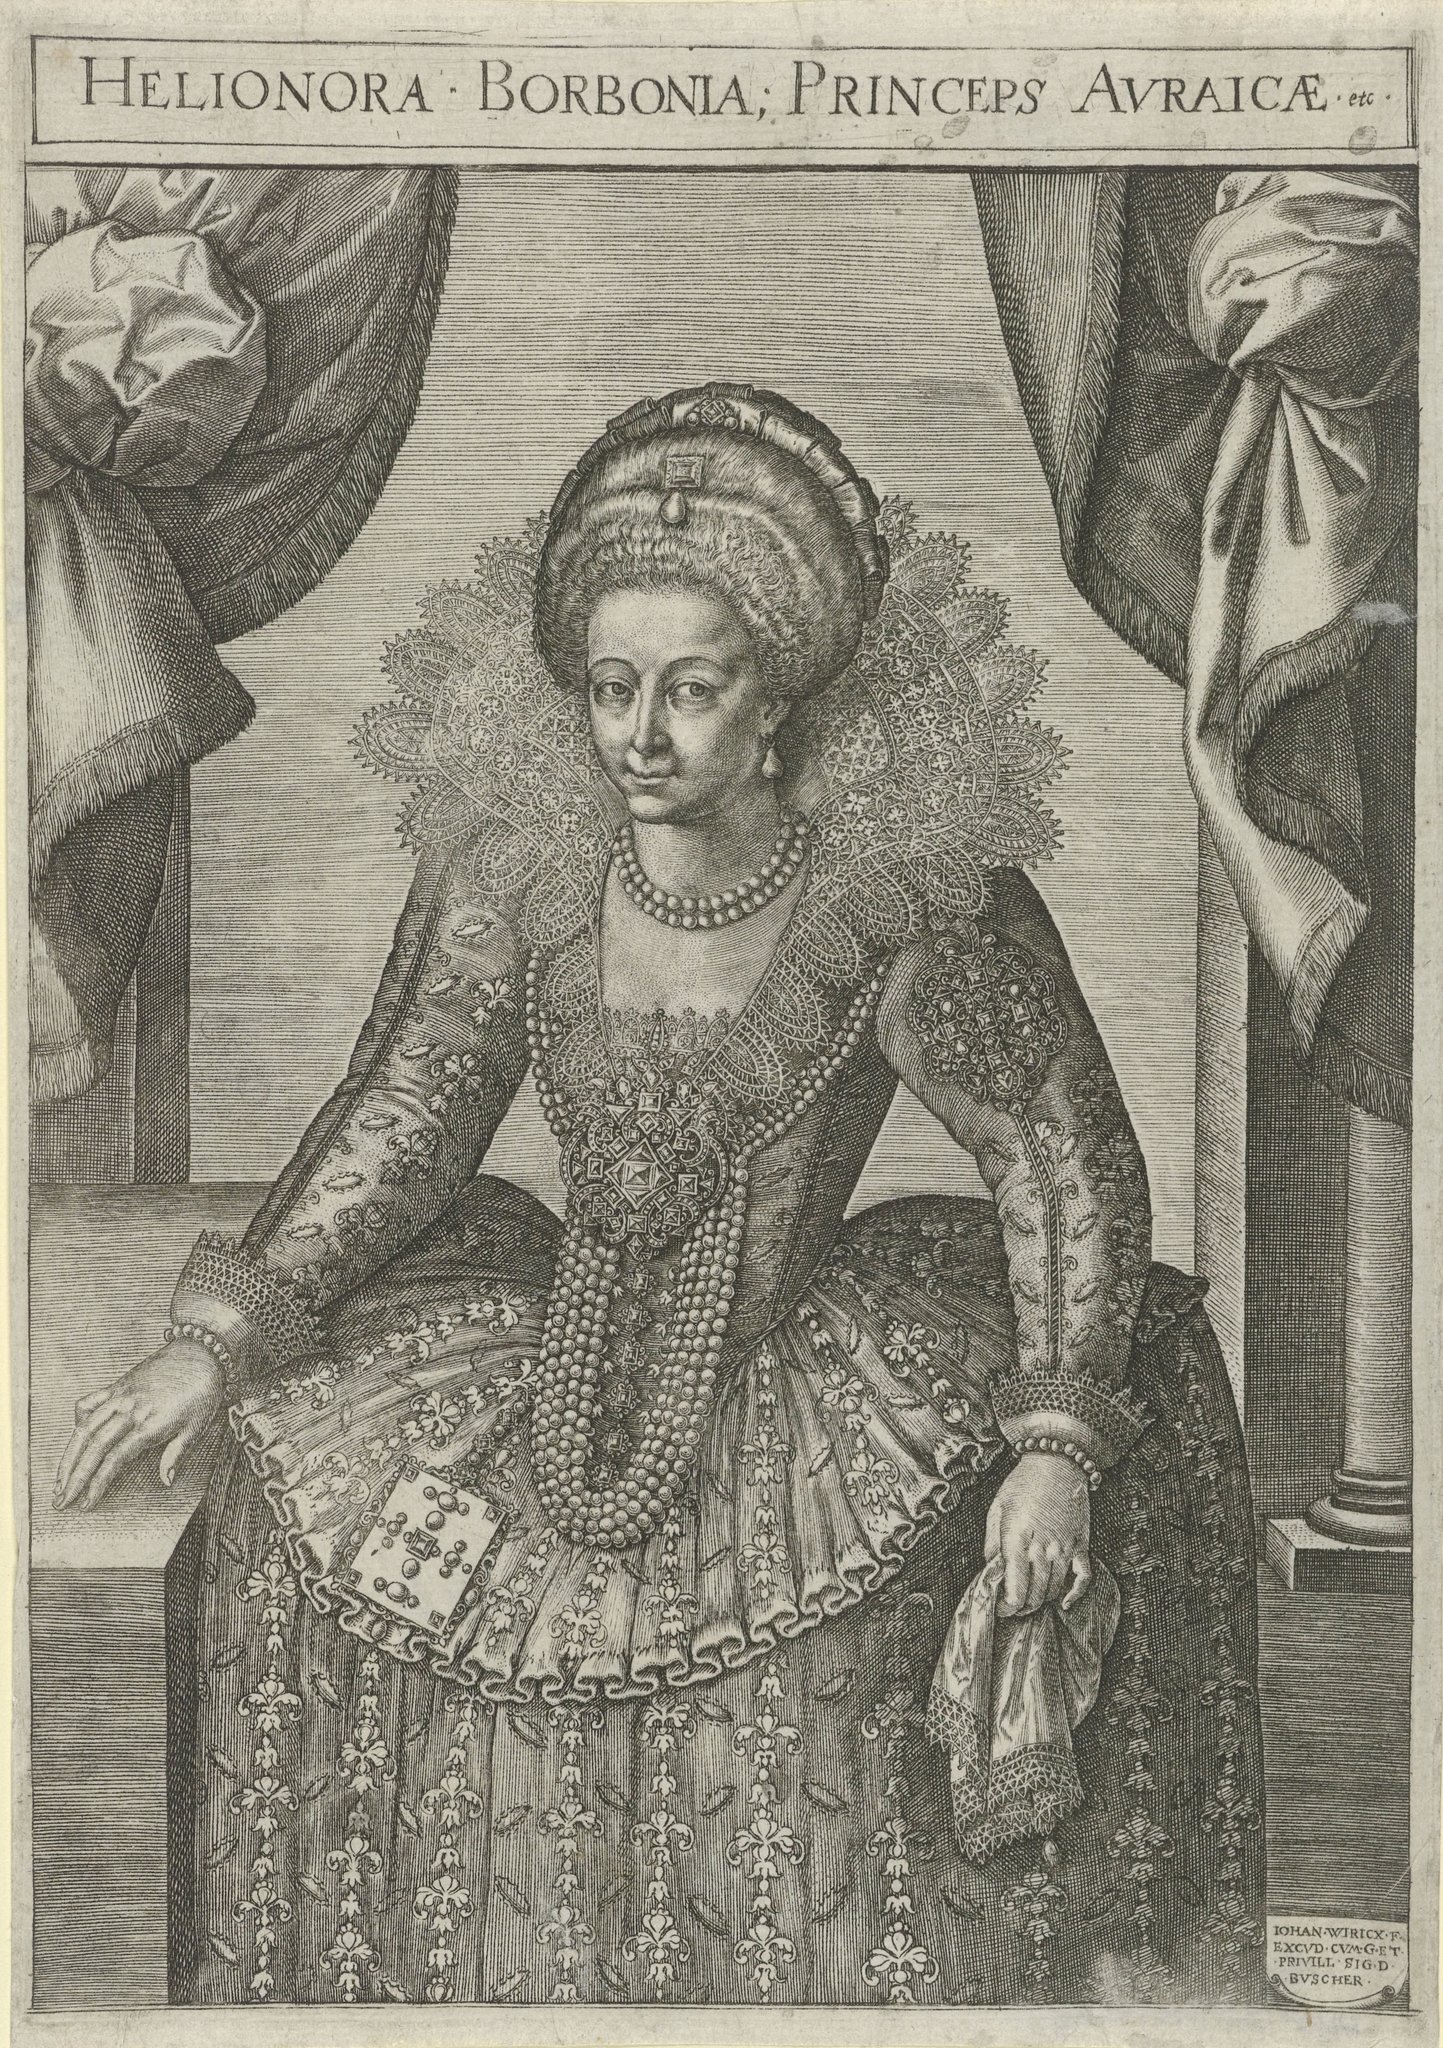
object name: print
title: Portret van Eleonora van Bourbon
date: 1600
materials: paper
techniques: engraving, etching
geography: antwerp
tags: éléonore de bourbon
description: Portret van Eleonora. In haar linkerhand een zakdoek. In een kader haar naam.